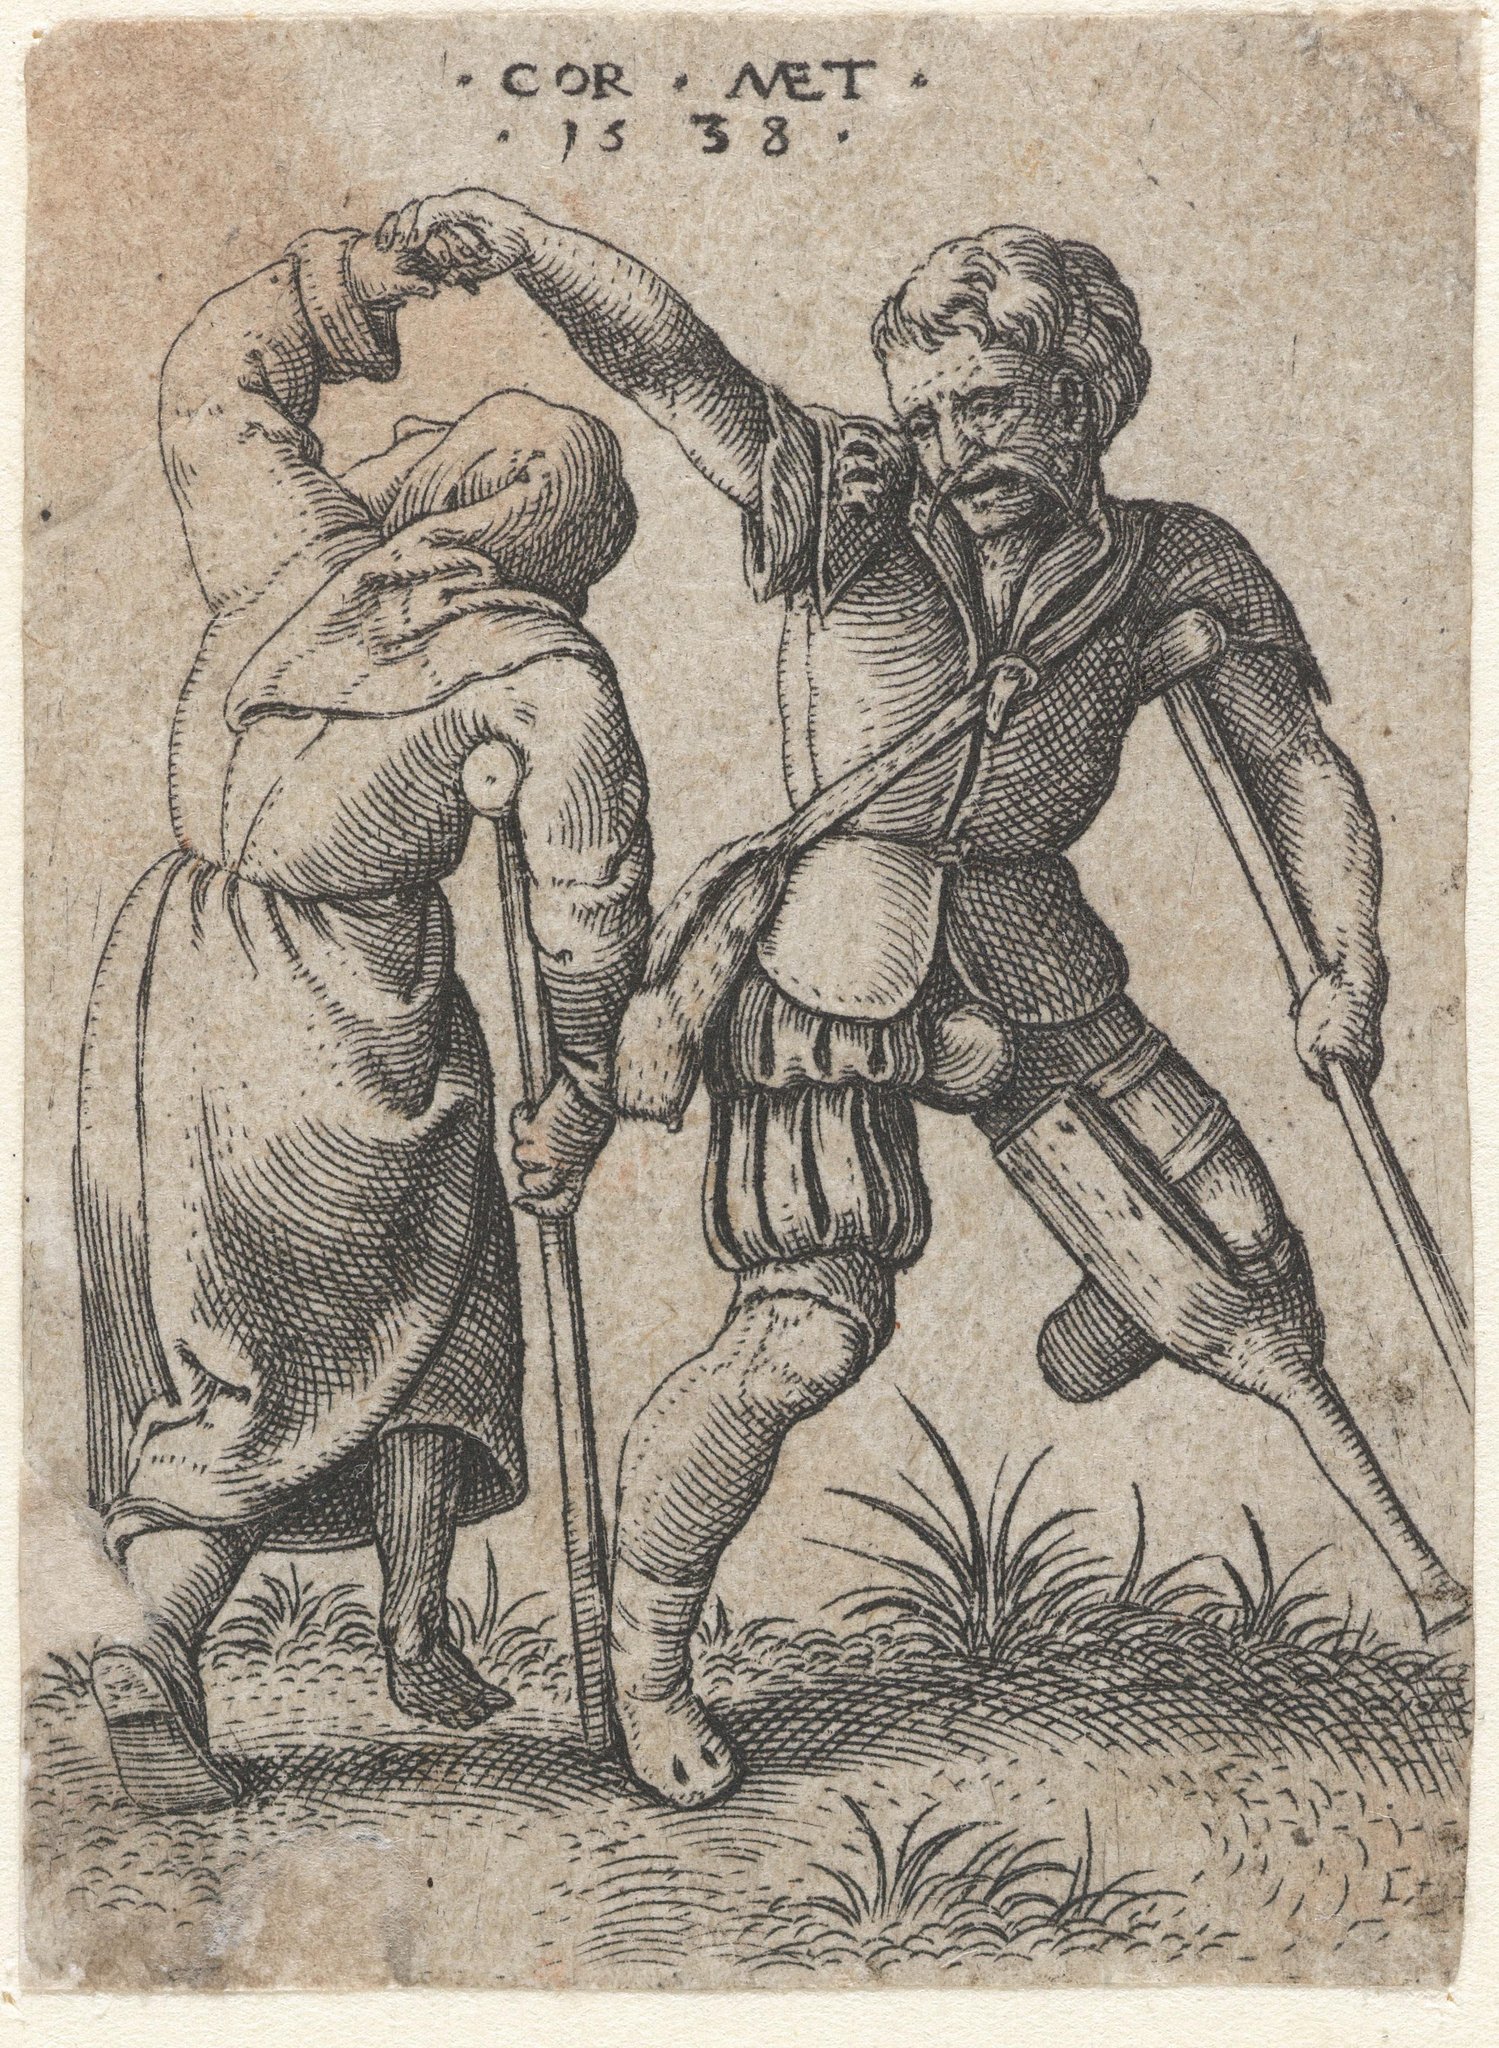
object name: print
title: Dansende kreupelen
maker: cornelis massijs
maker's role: painter, print maker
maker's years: 1510-1557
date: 1538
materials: paper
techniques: engraving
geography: antwerp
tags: dancing, crutches, one pair dancing; man and woman dancing as a couple, person with a physical disability, social stratification, social groups, disabled soldier, folk costume, regional costume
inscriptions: date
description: In de tijd waarin deze serie ontstond was 'kreupel' een generiek woord om een lichamelijke beperking aan het onderlichaam te beschrijven. Deze serie is sociale satire. Een soldaat met een houten been en een kruk danst met een vrouw, die ook op een kruk steunt.